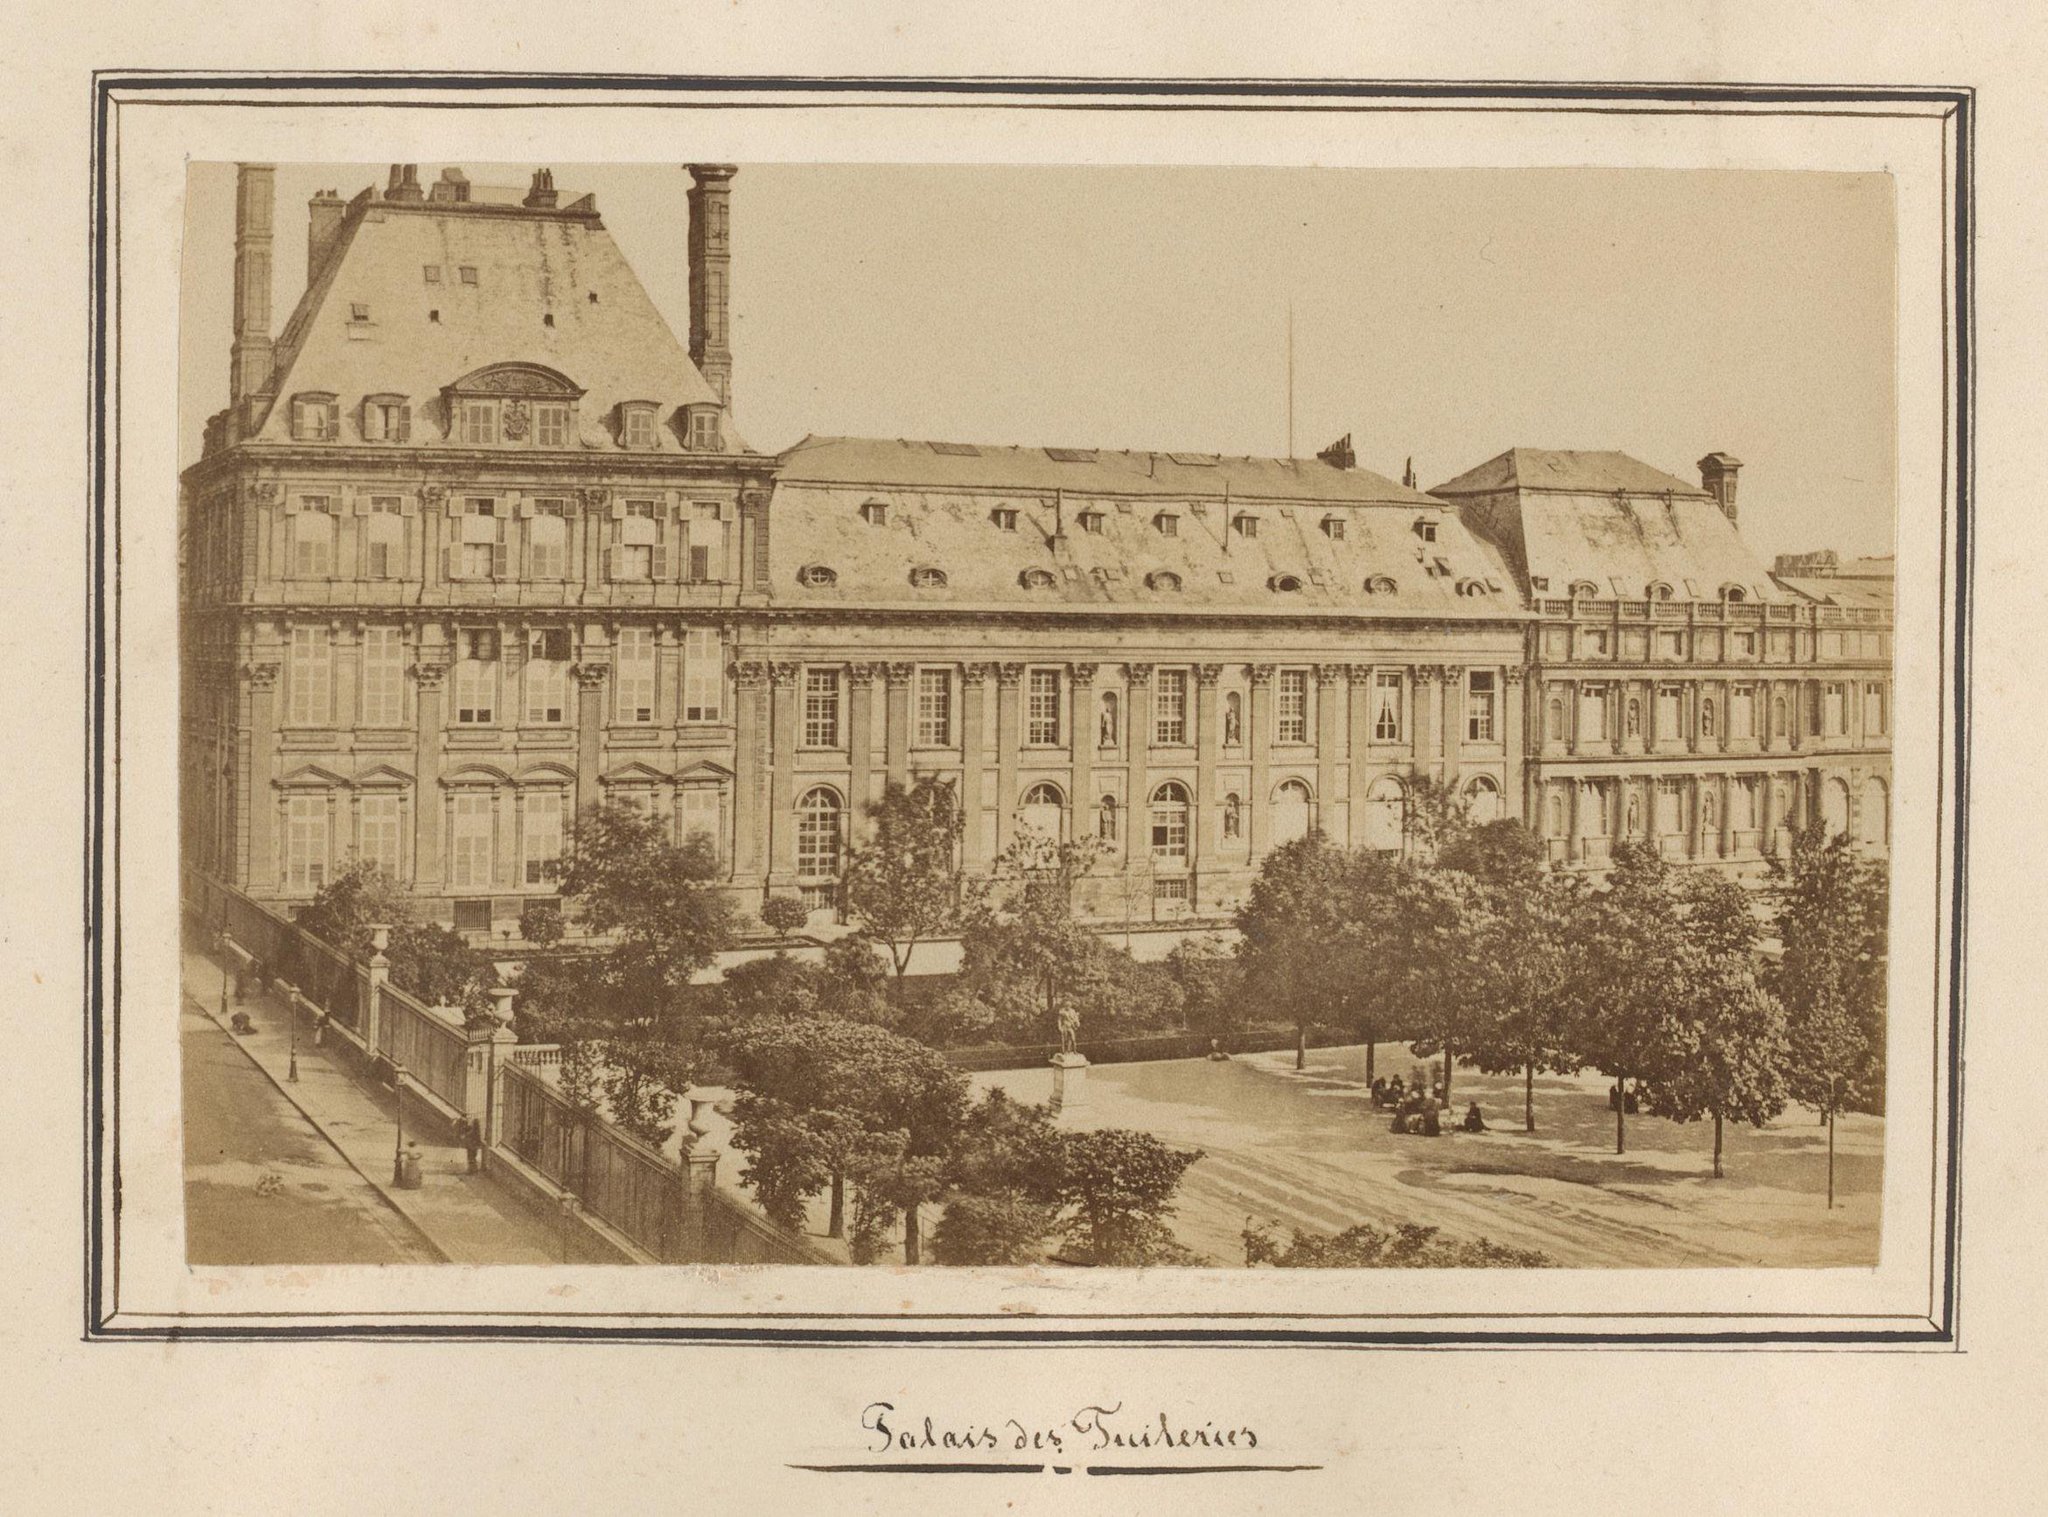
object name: photograph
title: Tuilerieënpaleis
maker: Anonymous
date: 1865-1871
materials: paper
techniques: albumen print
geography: paris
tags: palace, tuileries palace